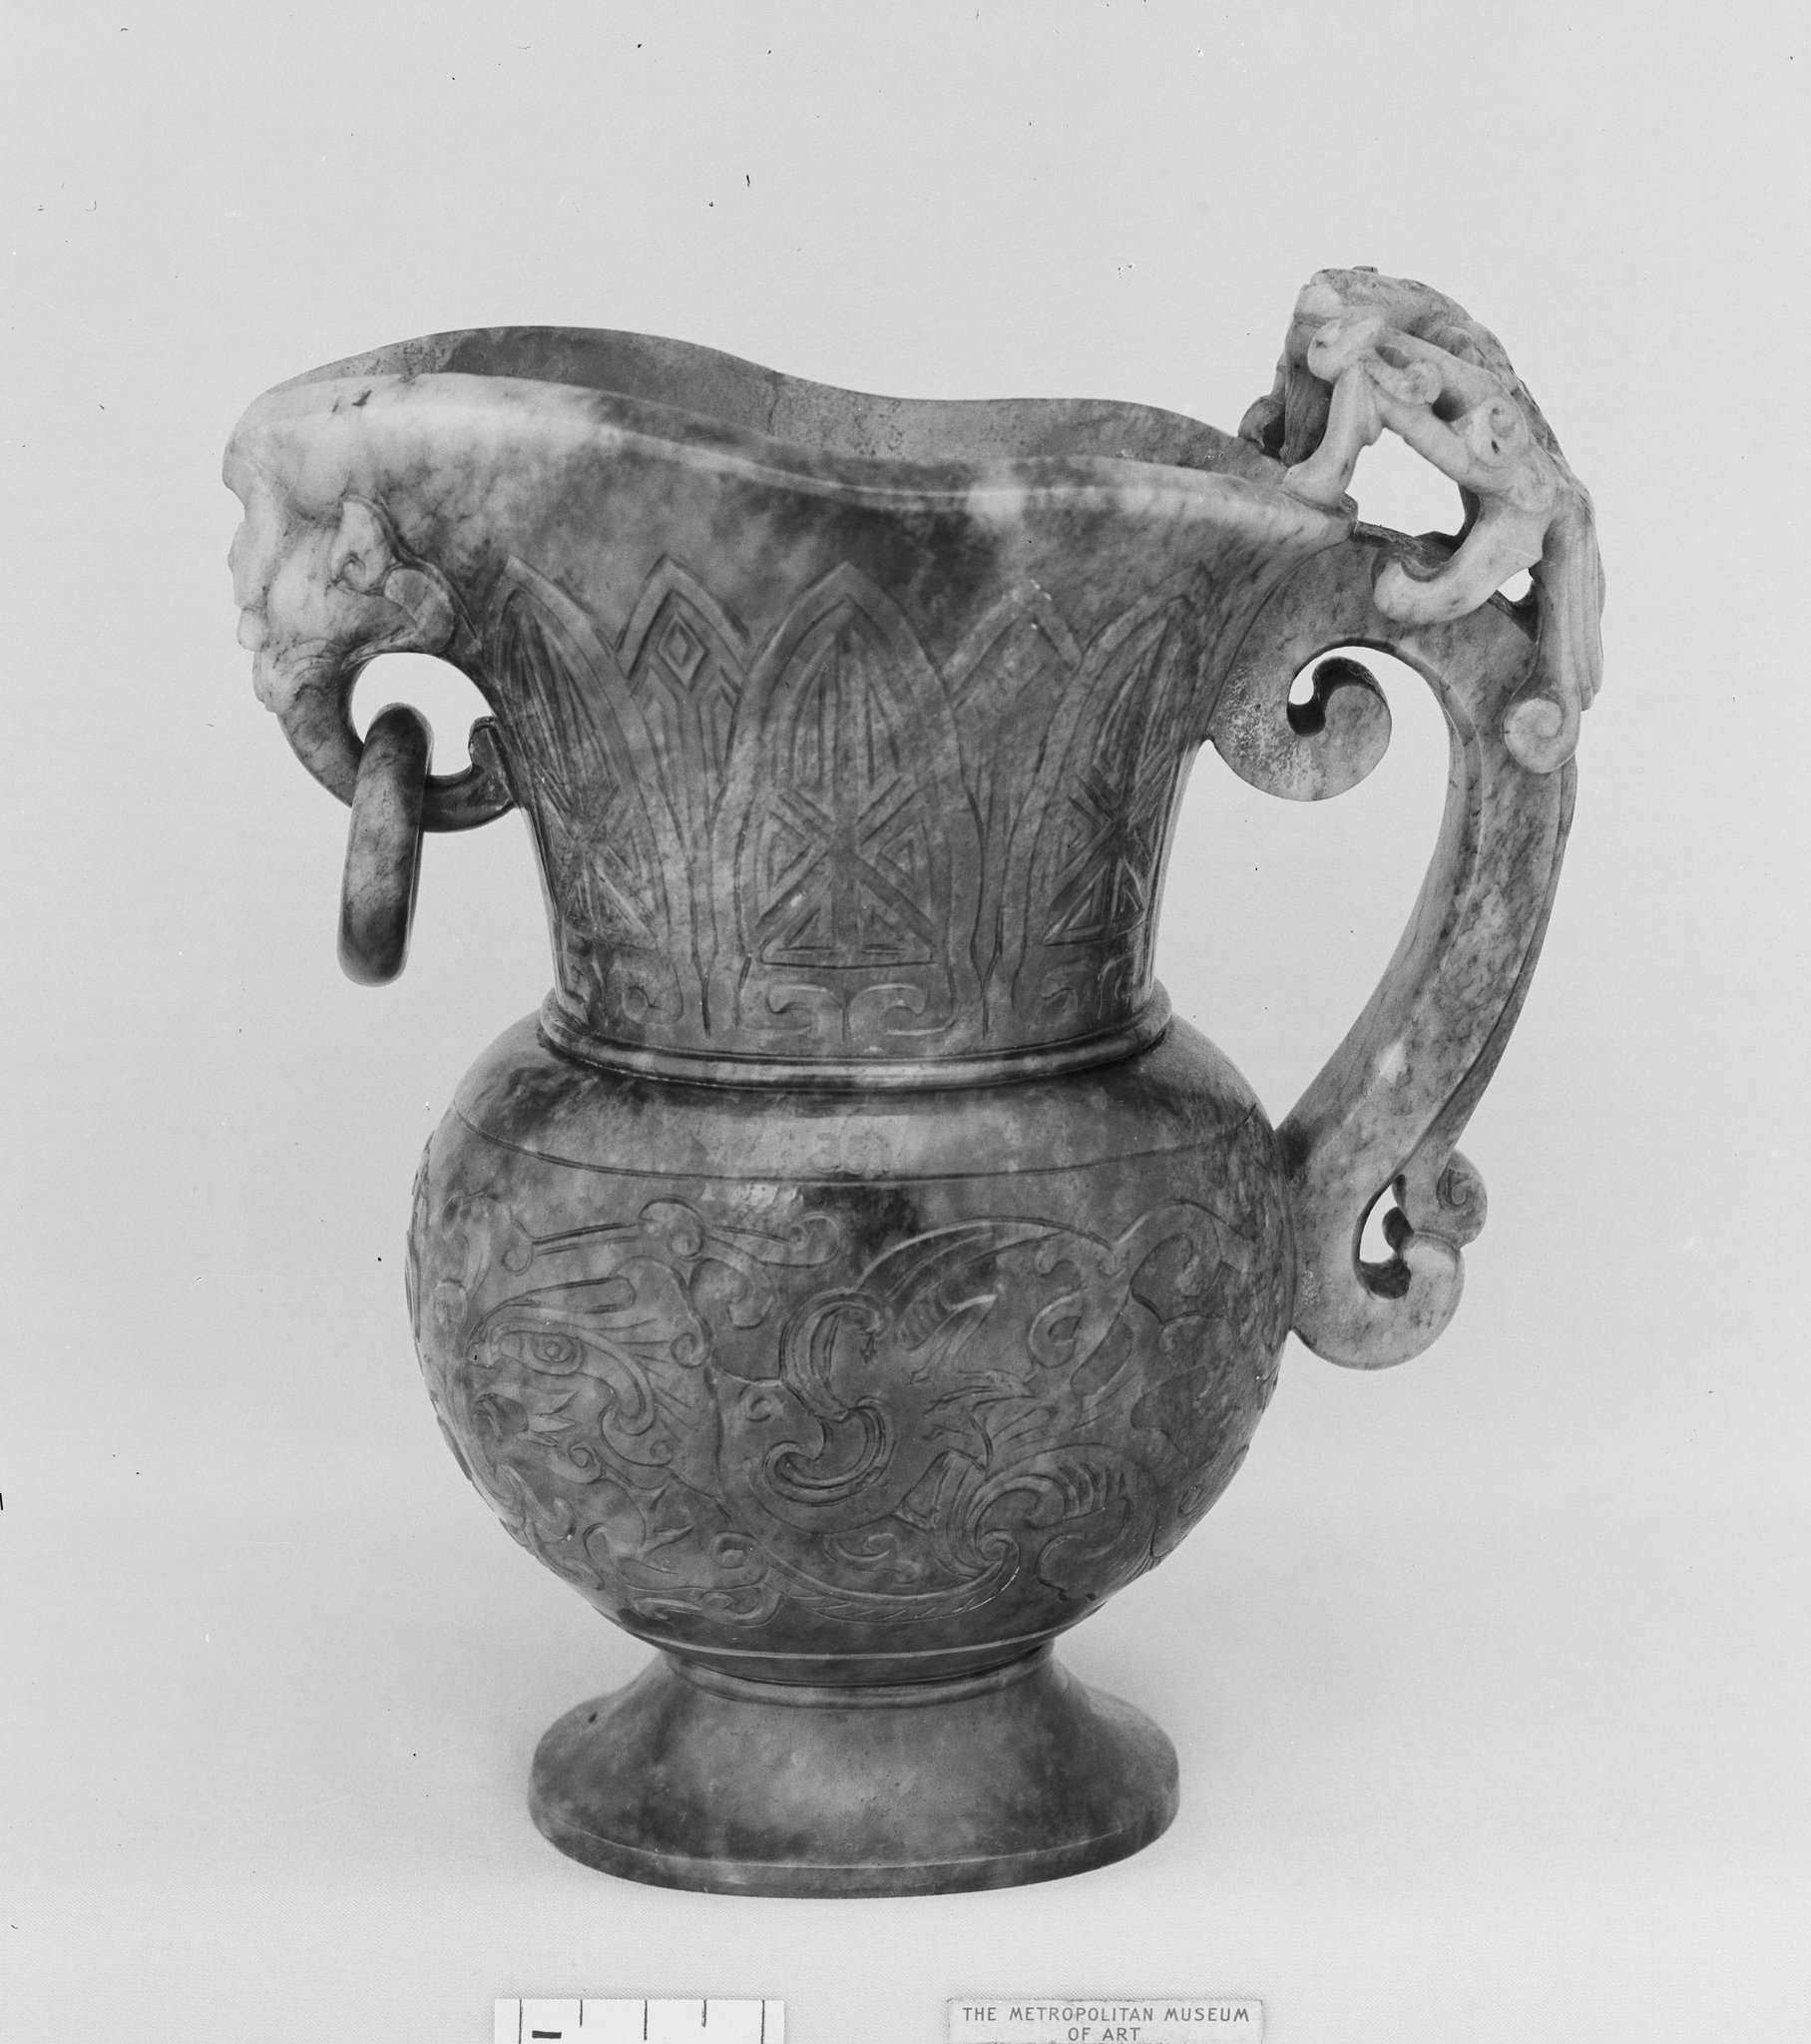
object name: wine jug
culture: chinese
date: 1300-1367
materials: jade